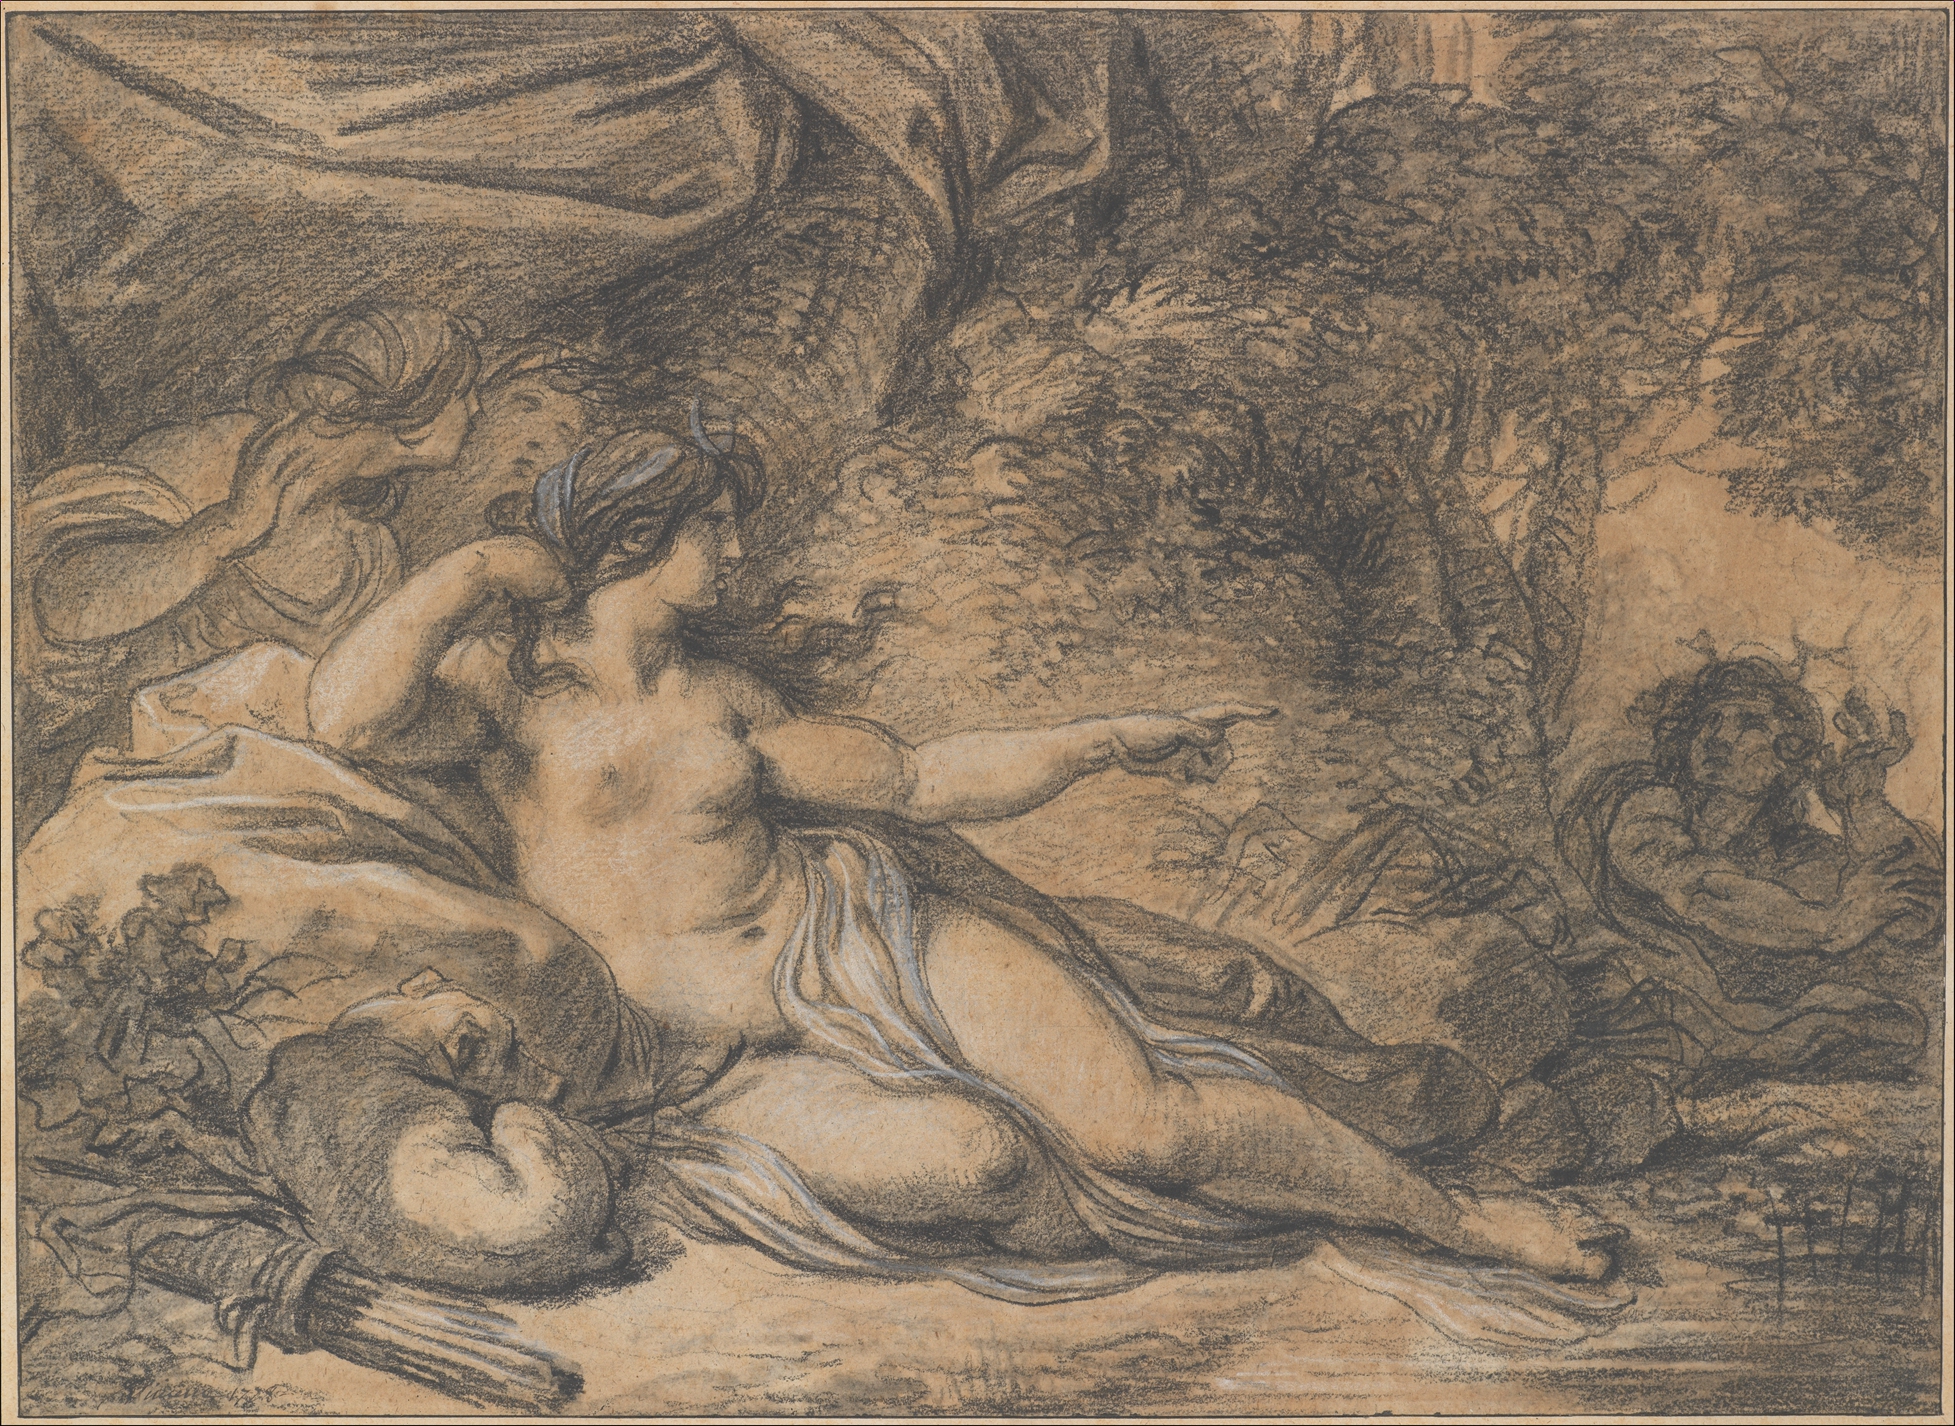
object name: drawing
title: Diana and Acteon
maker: françois andré vincent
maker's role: artist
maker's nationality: french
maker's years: 1746-1816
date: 1778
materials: chalk, charcoal, paper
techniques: heightening, stumping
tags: men,diana,dogs,trees